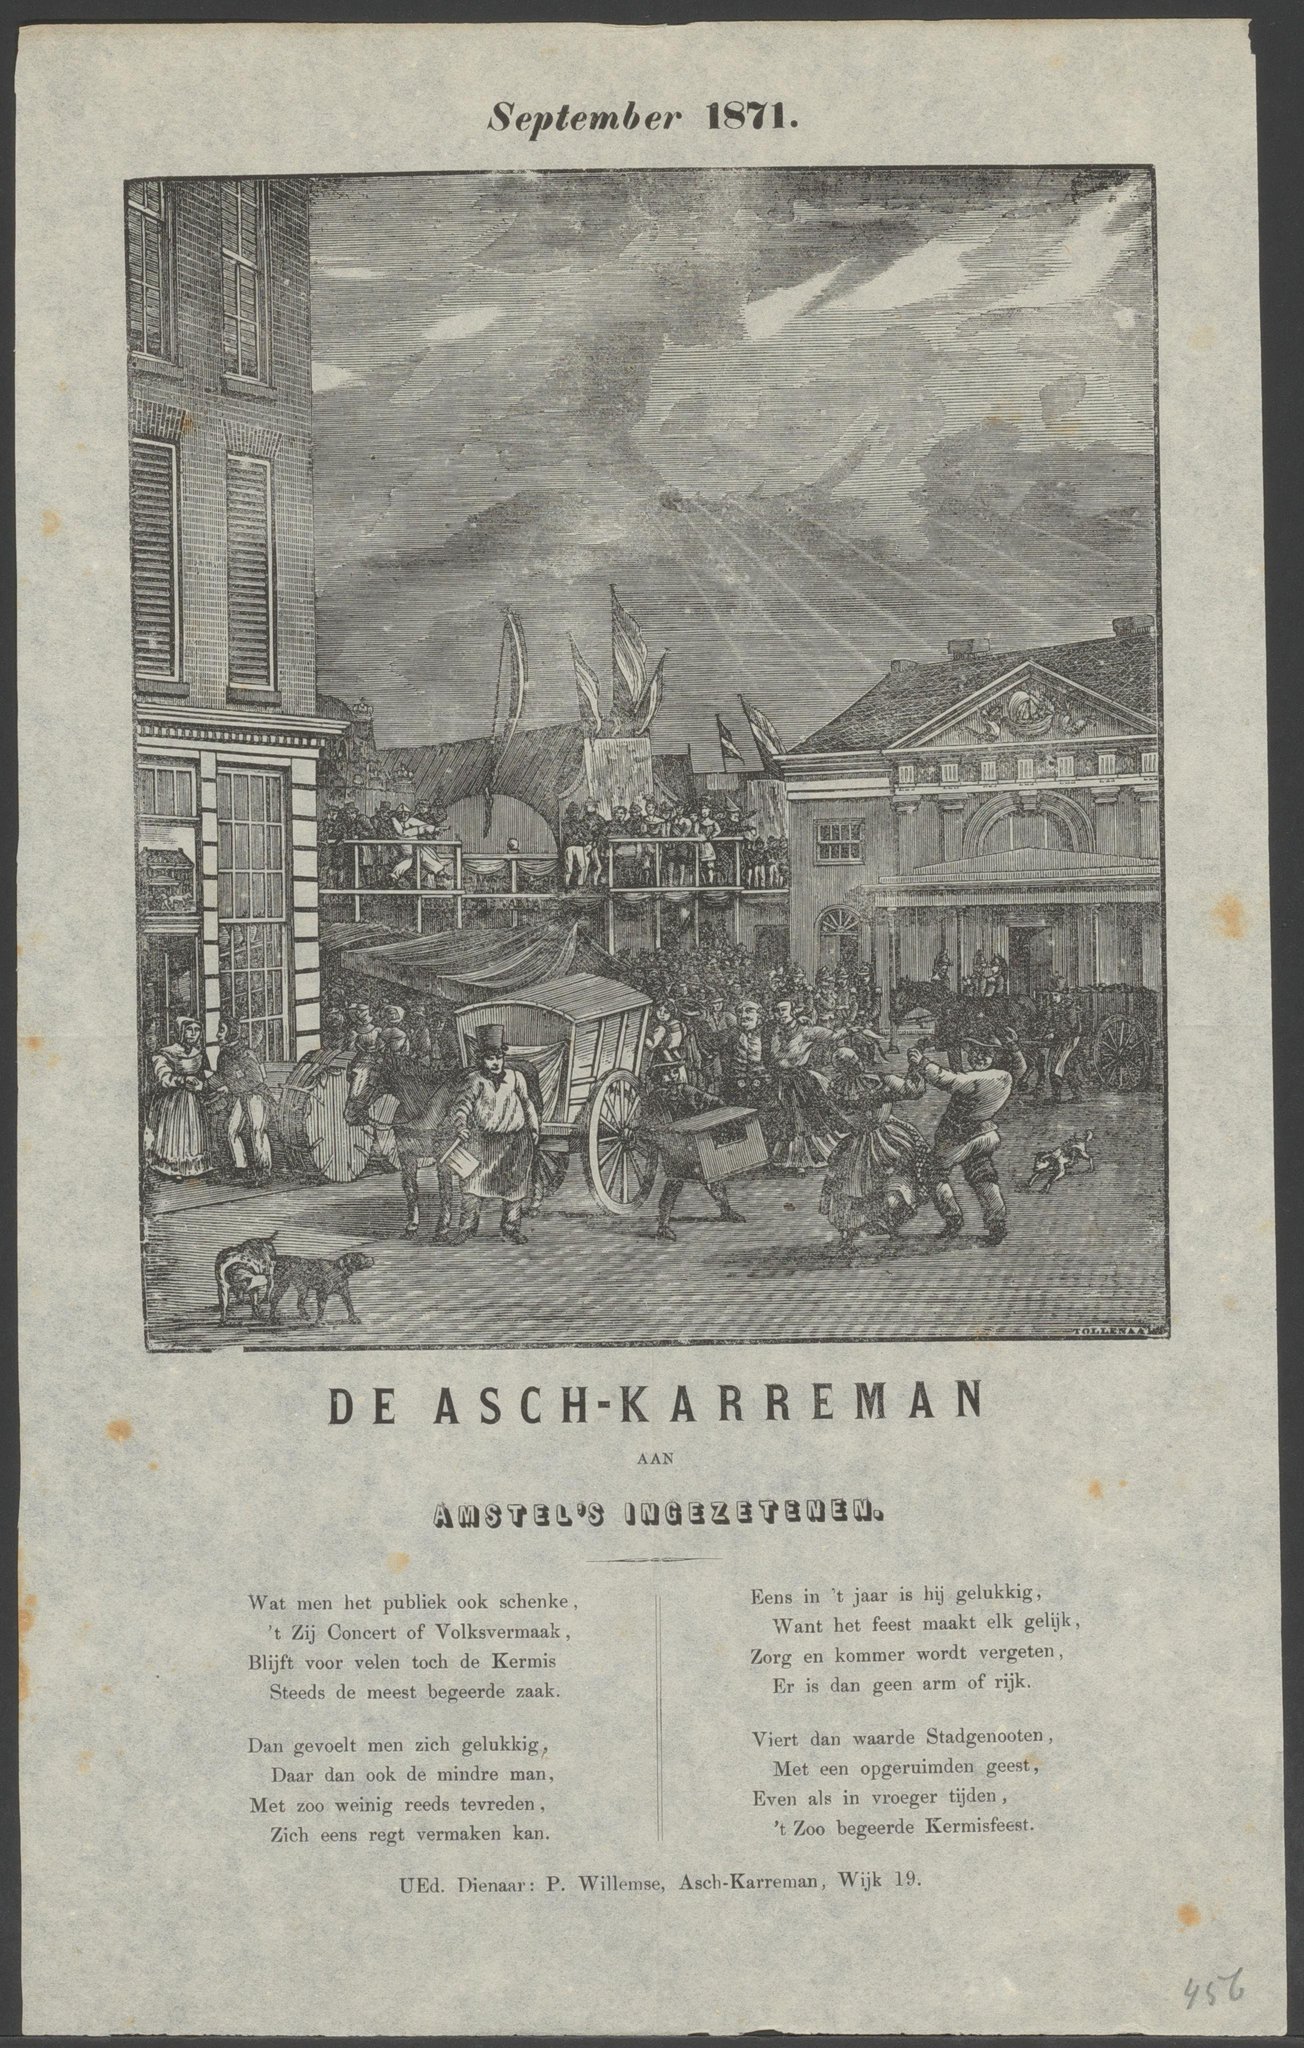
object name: fair print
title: Kermisprent van de Amsterdamse askarrenmannen voor het jaar 1871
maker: dirk wijbrand tollenaar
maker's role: print maker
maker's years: 1808-1858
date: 1871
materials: paper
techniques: letterpress printing, engraving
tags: pleasure fair and circus, garbage collection, amsterdam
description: Kermisprent namens de askarrenmannen (karrenman of vuilnisman) te Amsterdam, september 1871. Gezicht op de kermis op de Botermarkt met de Regulierswaag. Op de markt twee vuilniskarren. Onderaan een gedicht in twee kolommen. Namens P. Willemse, de askarreman van wijk no. 19. Onderwerpsrubrieken binnen de Atlas Zeden en Gewoonten: Zeden en gewoonten in engeren zin, Volksleven, Volksbladen, Nieuwjaars- en Kerstwenschen, Amsterdam.